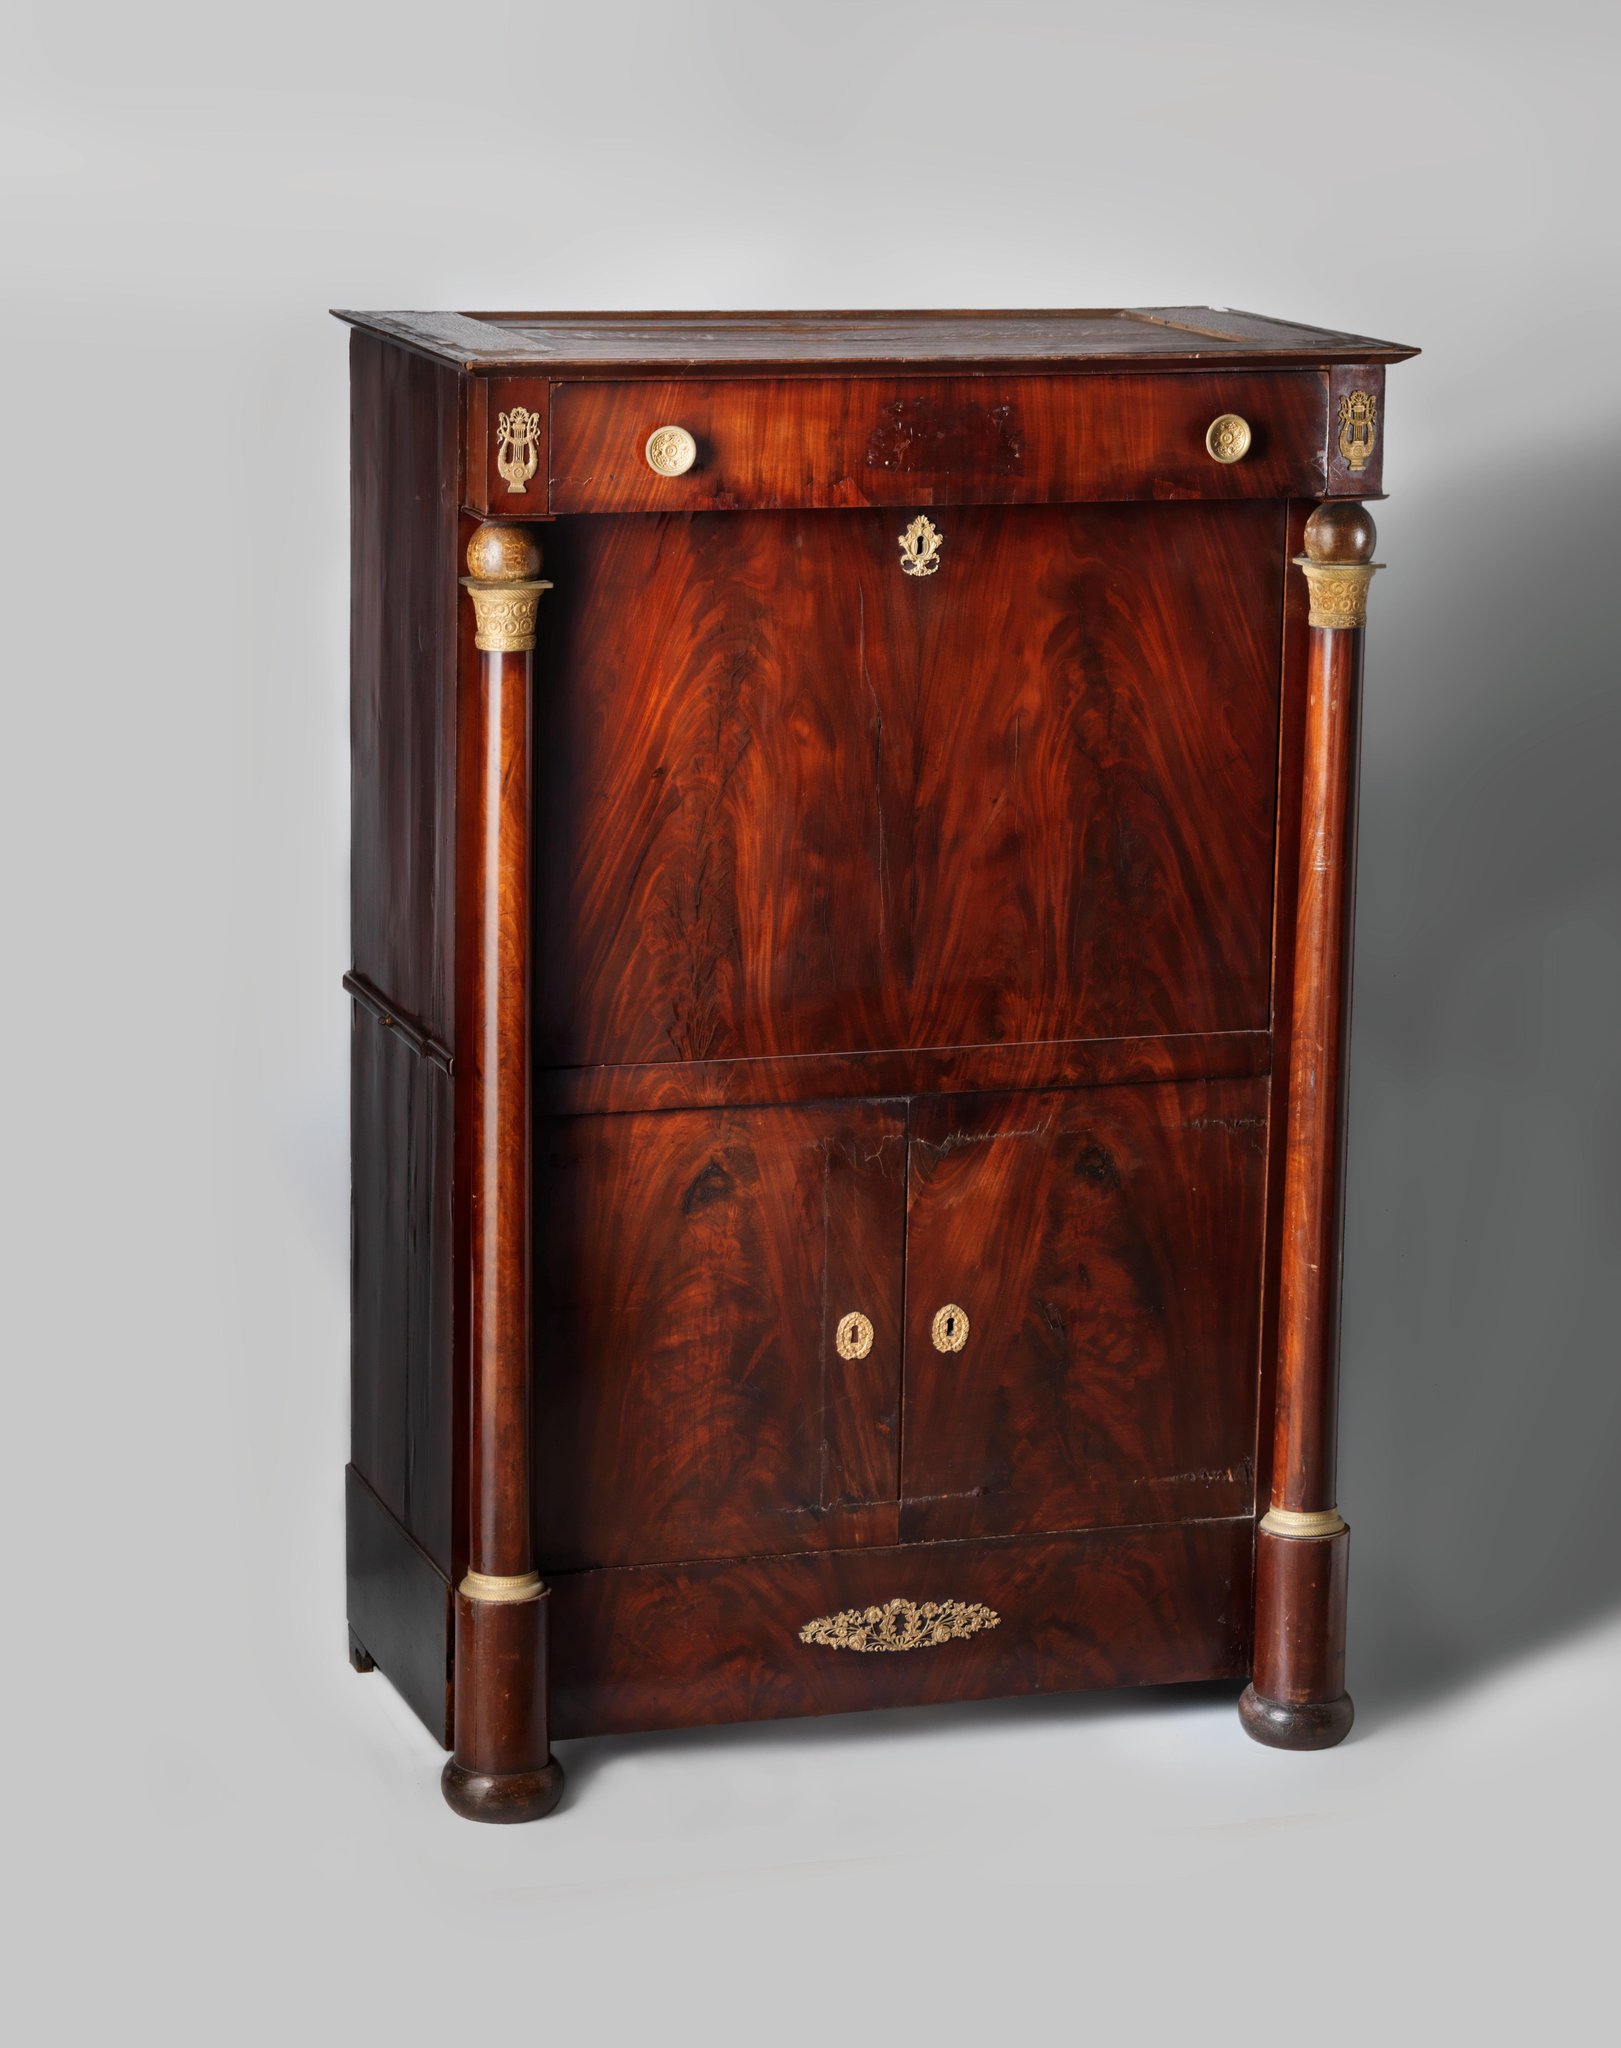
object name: furniture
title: Secretaire, o.a. versierd met Mercurius op een door een paard getrokken wagen in de wolken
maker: Anonymous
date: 1820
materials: bronze, glass, wood, marble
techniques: gilding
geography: northern netherlands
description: Secretaire van eike- en vurenhout belijmd met mahoniehout. Op de hoeken aan de voorzijde zijn twee vrijstaande zuilen op basementen aangebracht. Het basement en het kapiteel dat een geschilderde bol draagt zijn van verguld brons, evenals het beslag onder en op de deuren en het schrijfblad; dat van de bovenlade in het vooruitspringende fries, steunend op de zuilen, stelt Mercurius op een door een paard getrokken wagen in de wolken voor. Achter het schrijfblad spiegels en plankjes. Grijs geaderd marmeren blad.